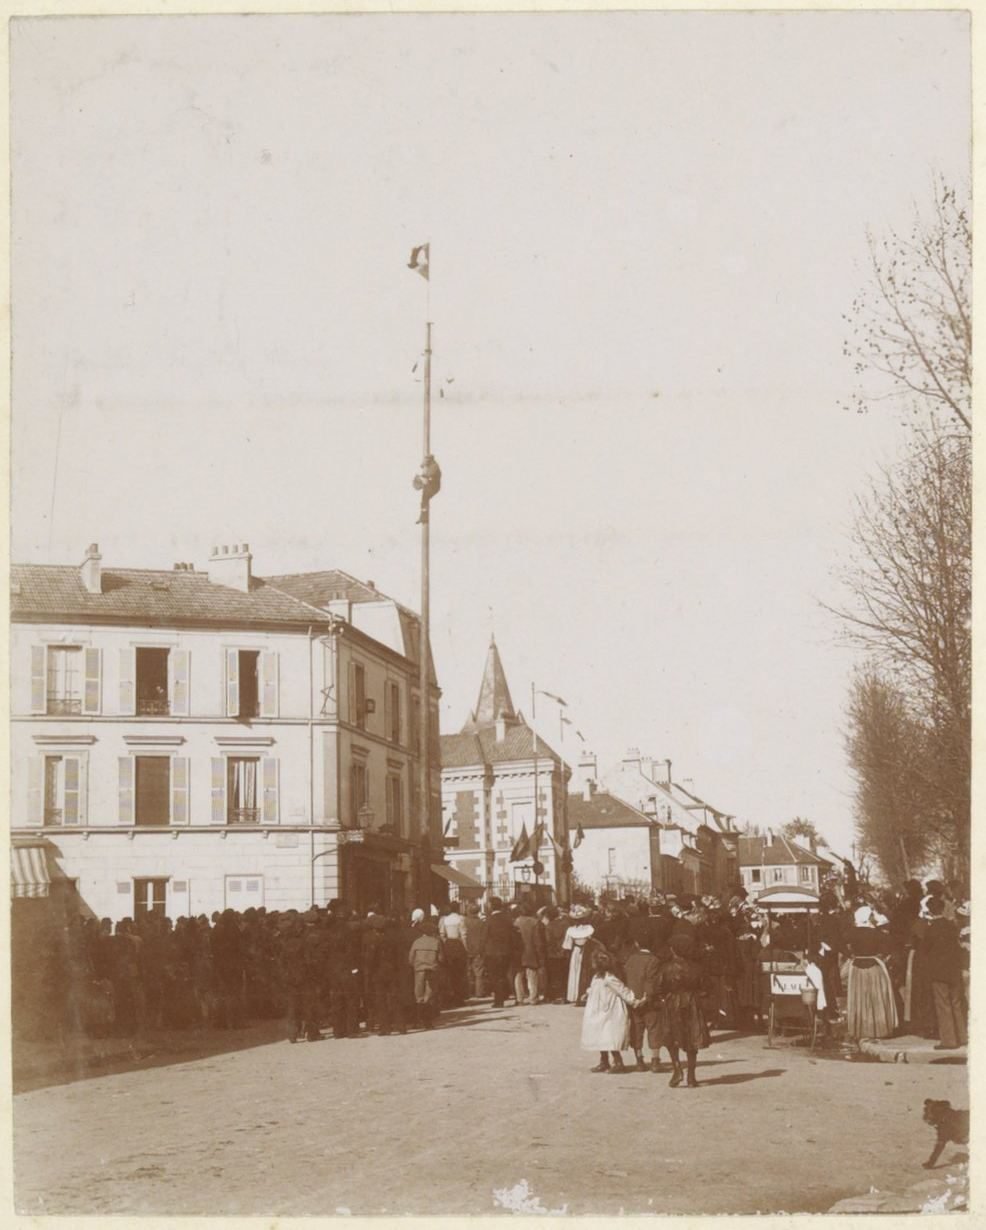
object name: photograph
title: Publiek kijkt toe hoe een man in een vlaggenmast klimt in Frankrijk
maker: Anonymous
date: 1900-1910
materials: paper, photographic support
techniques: daylight paper print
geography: france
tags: climbing, flagpole, france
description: Onderdeel van Fotoalbum van een Franse amateurfotograaf met opnames van een familie, distilleerderij Delizy & Doistau Fils, het leger en bezienswaardigheden in Frankrijk.